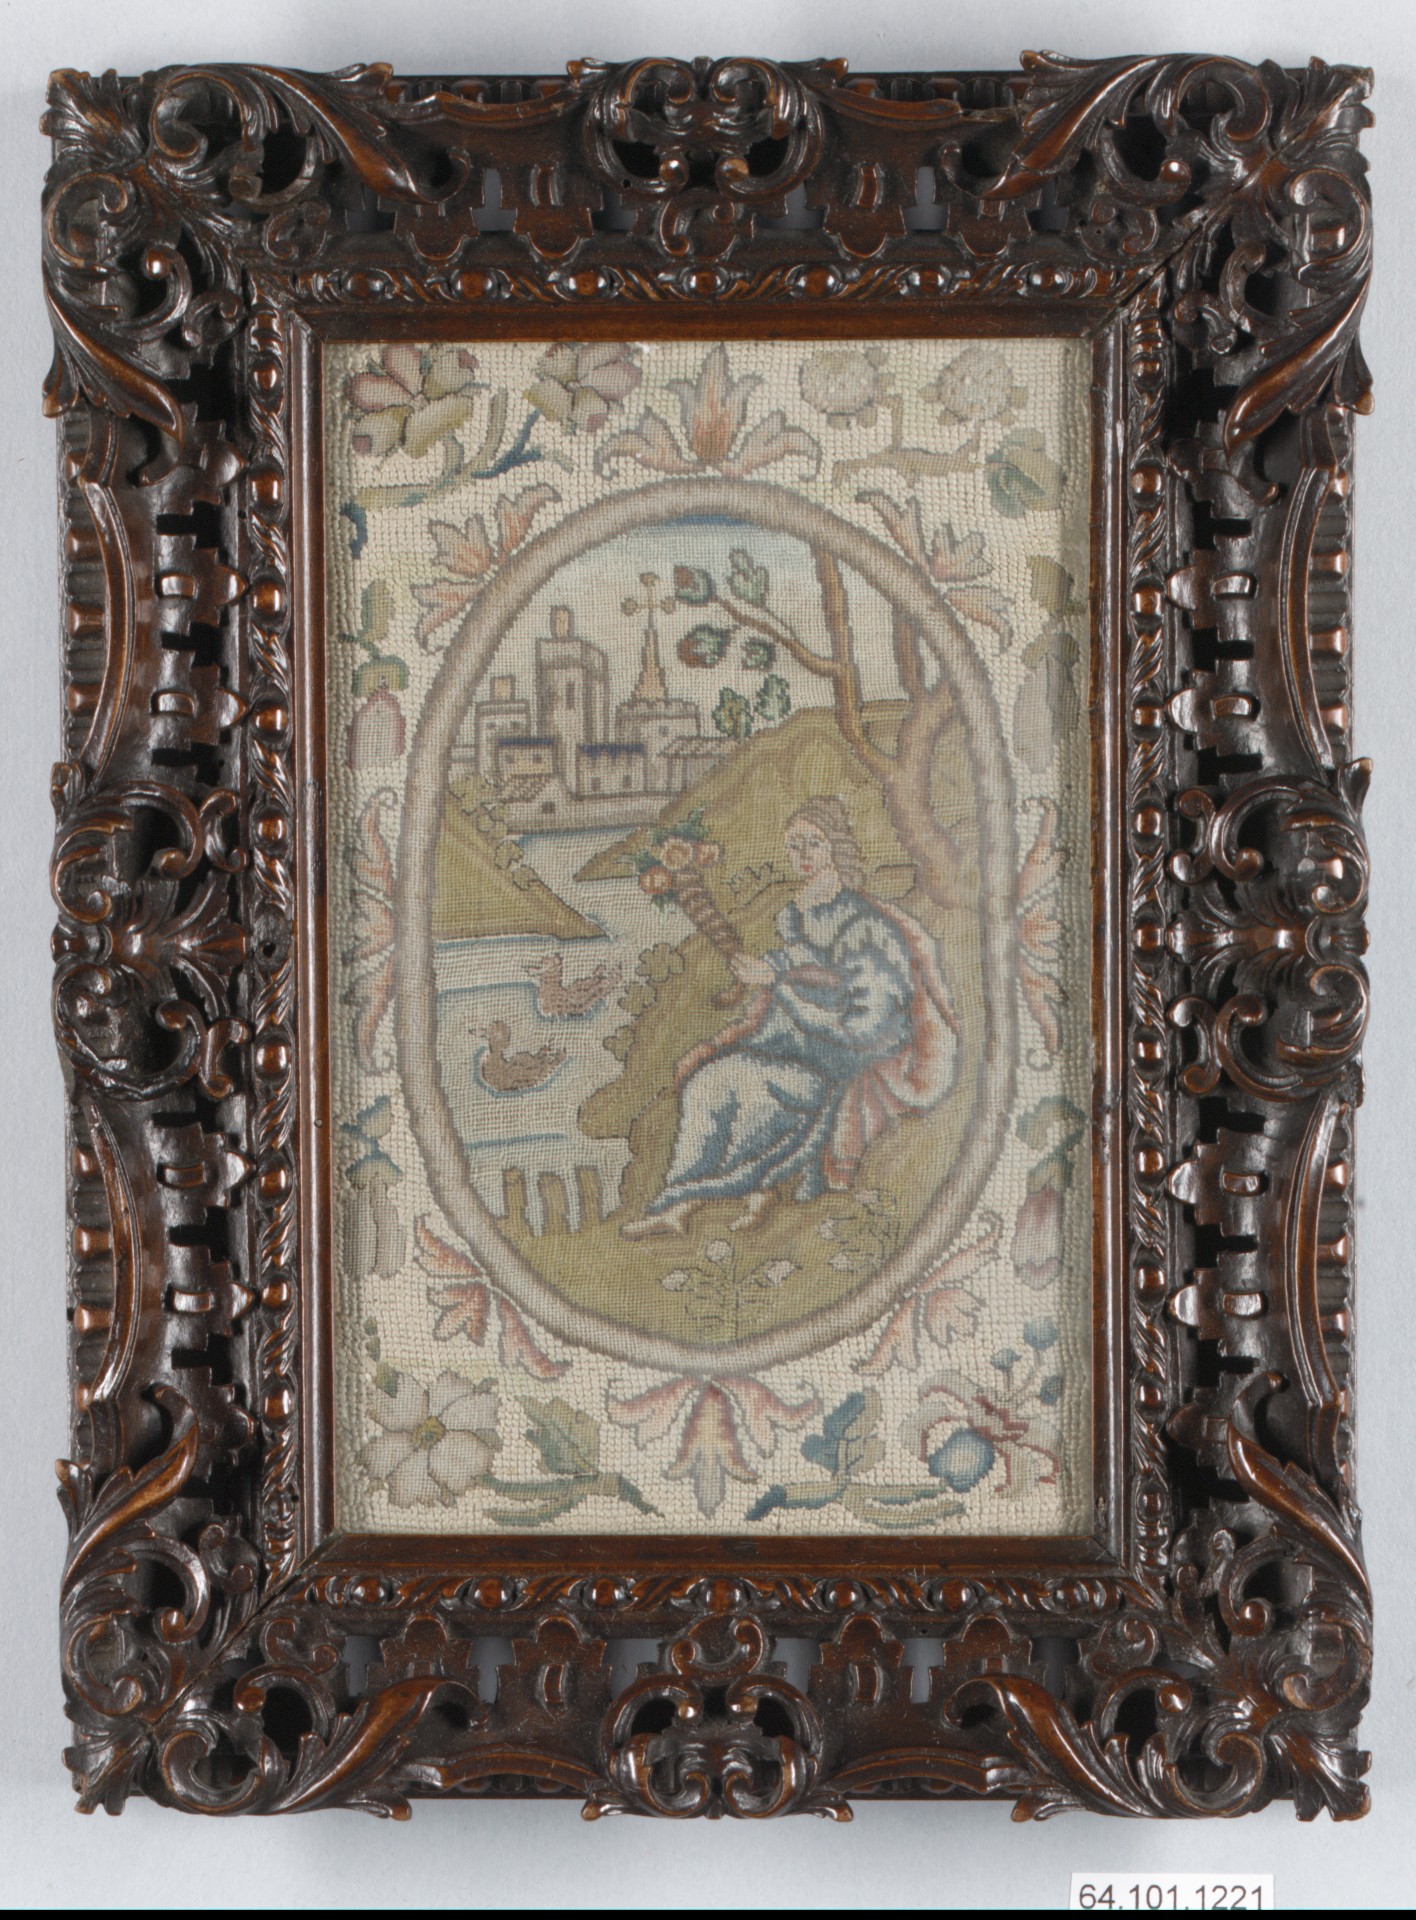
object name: embroidered picture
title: Woman holding flowers near a pond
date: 1601-1700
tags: ducks,women,flowers